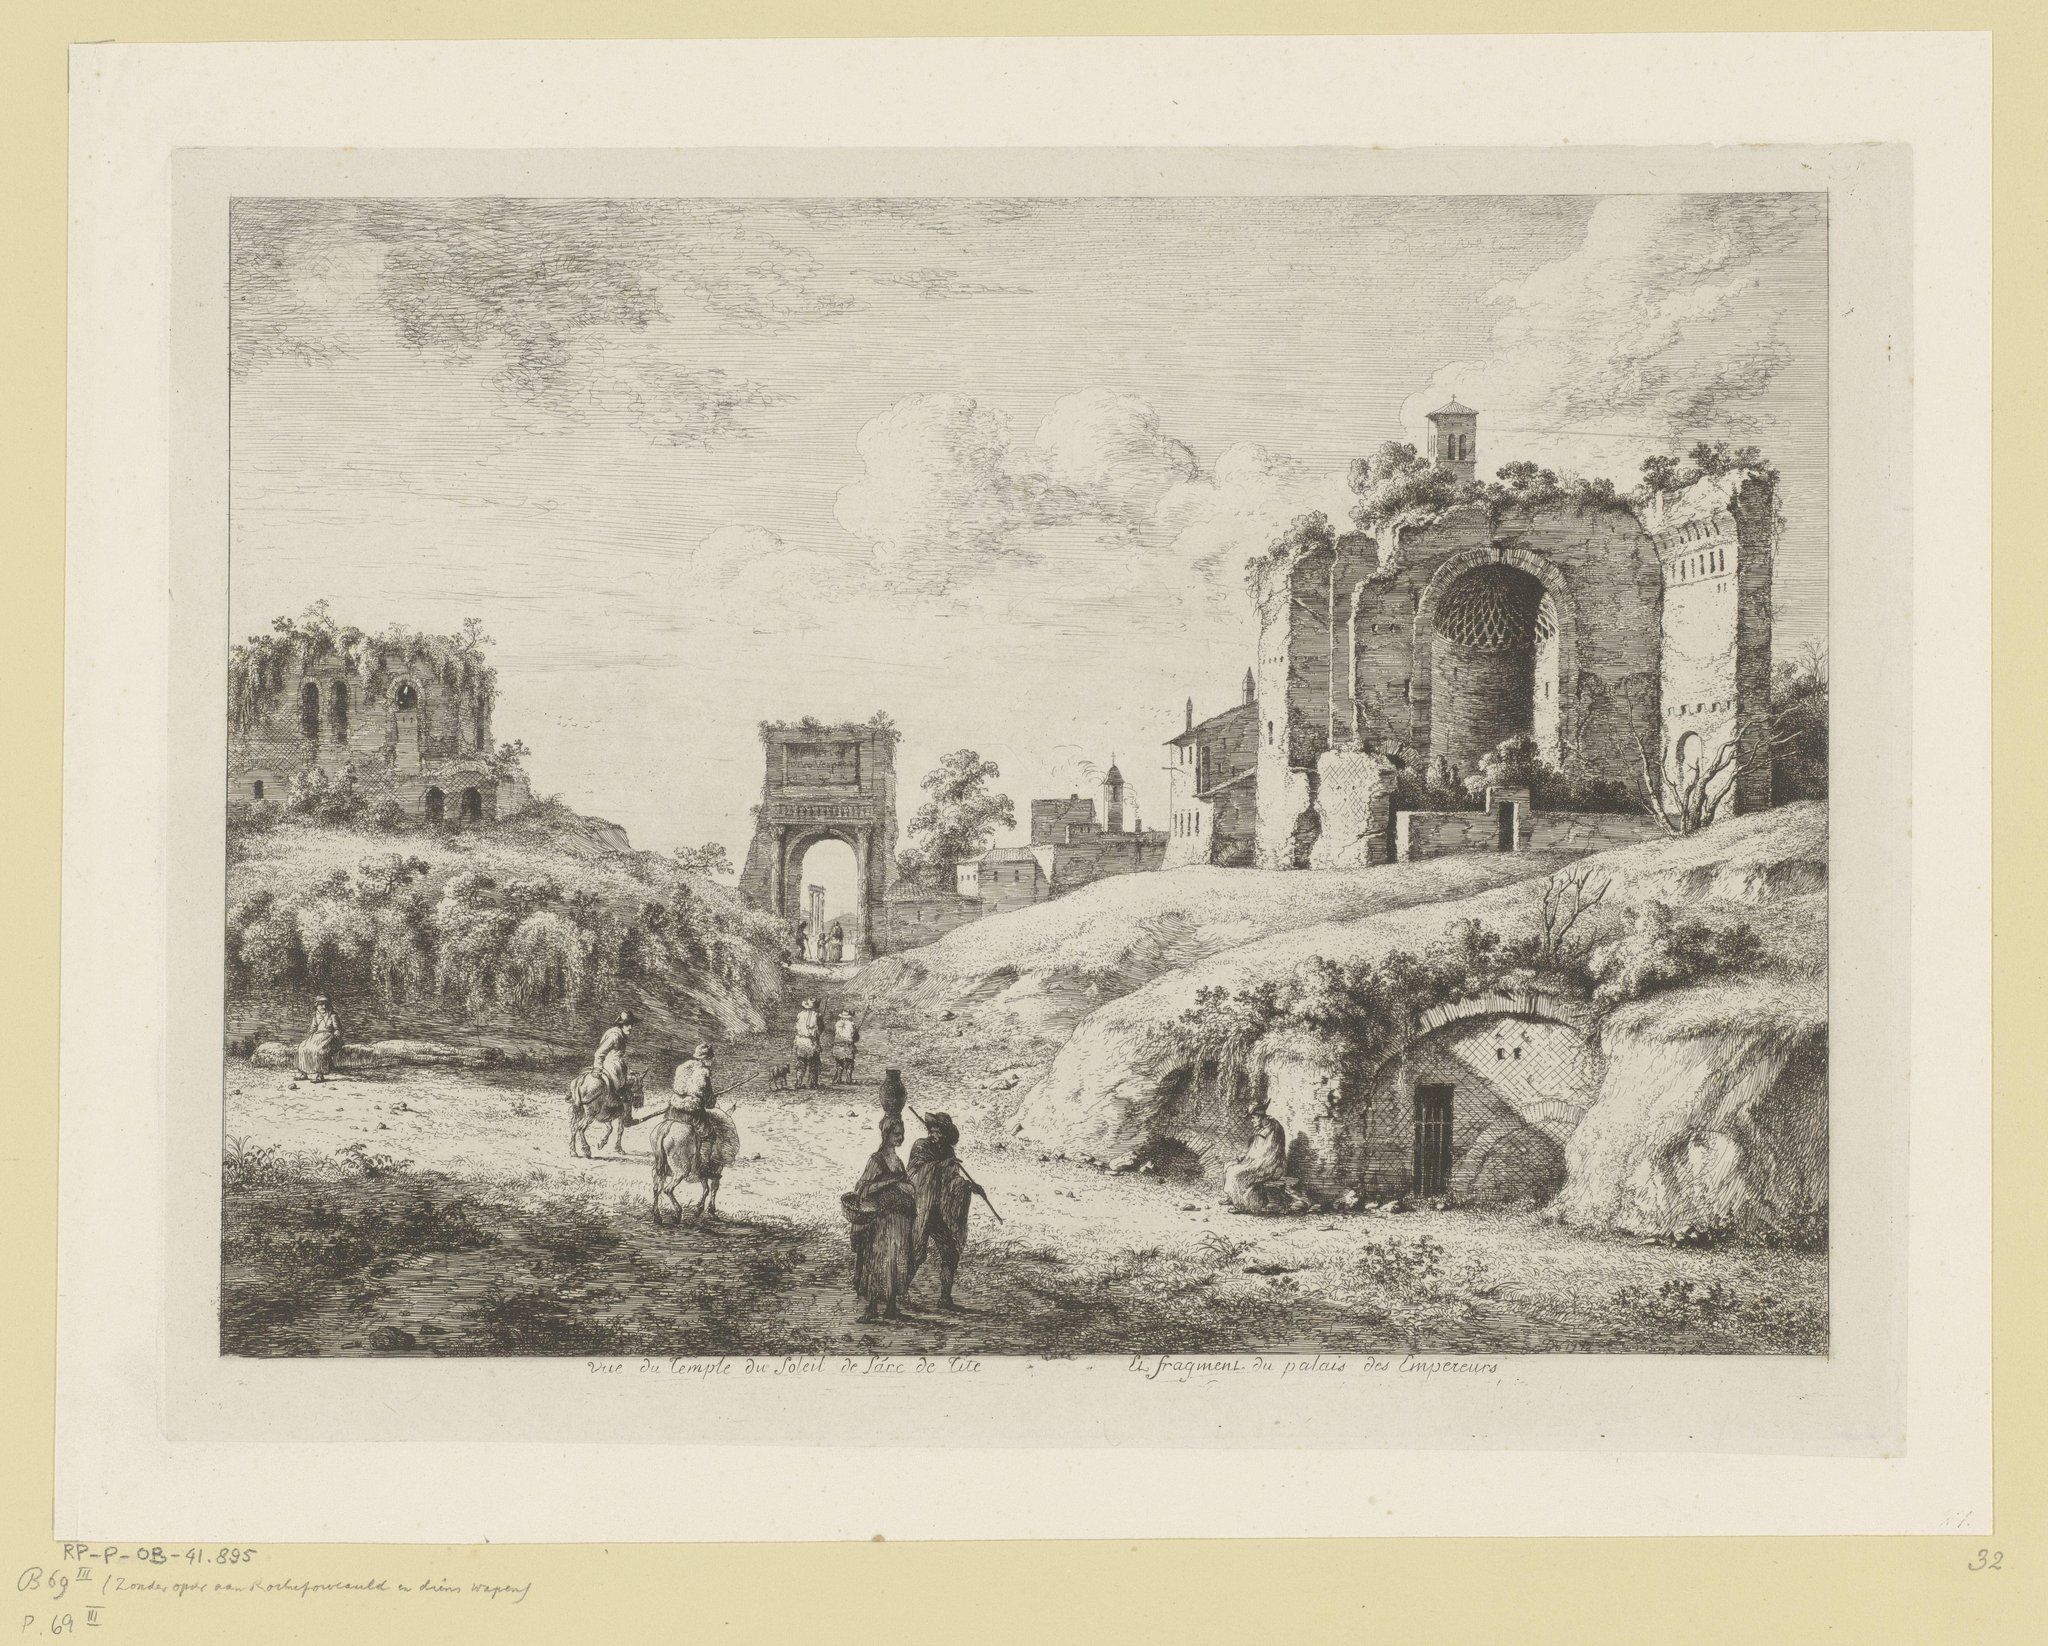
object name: print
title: Gezicht op het Forum Romanum met de Boog van Titus en de Tempel van Venus en Roma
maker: jean jacques de boissieu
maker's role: draughtsman, print maker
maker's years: 1736-1810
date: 1773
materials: paper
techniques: etching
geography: france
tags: landscape with ruins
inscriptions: collector's mark: Lugt 12